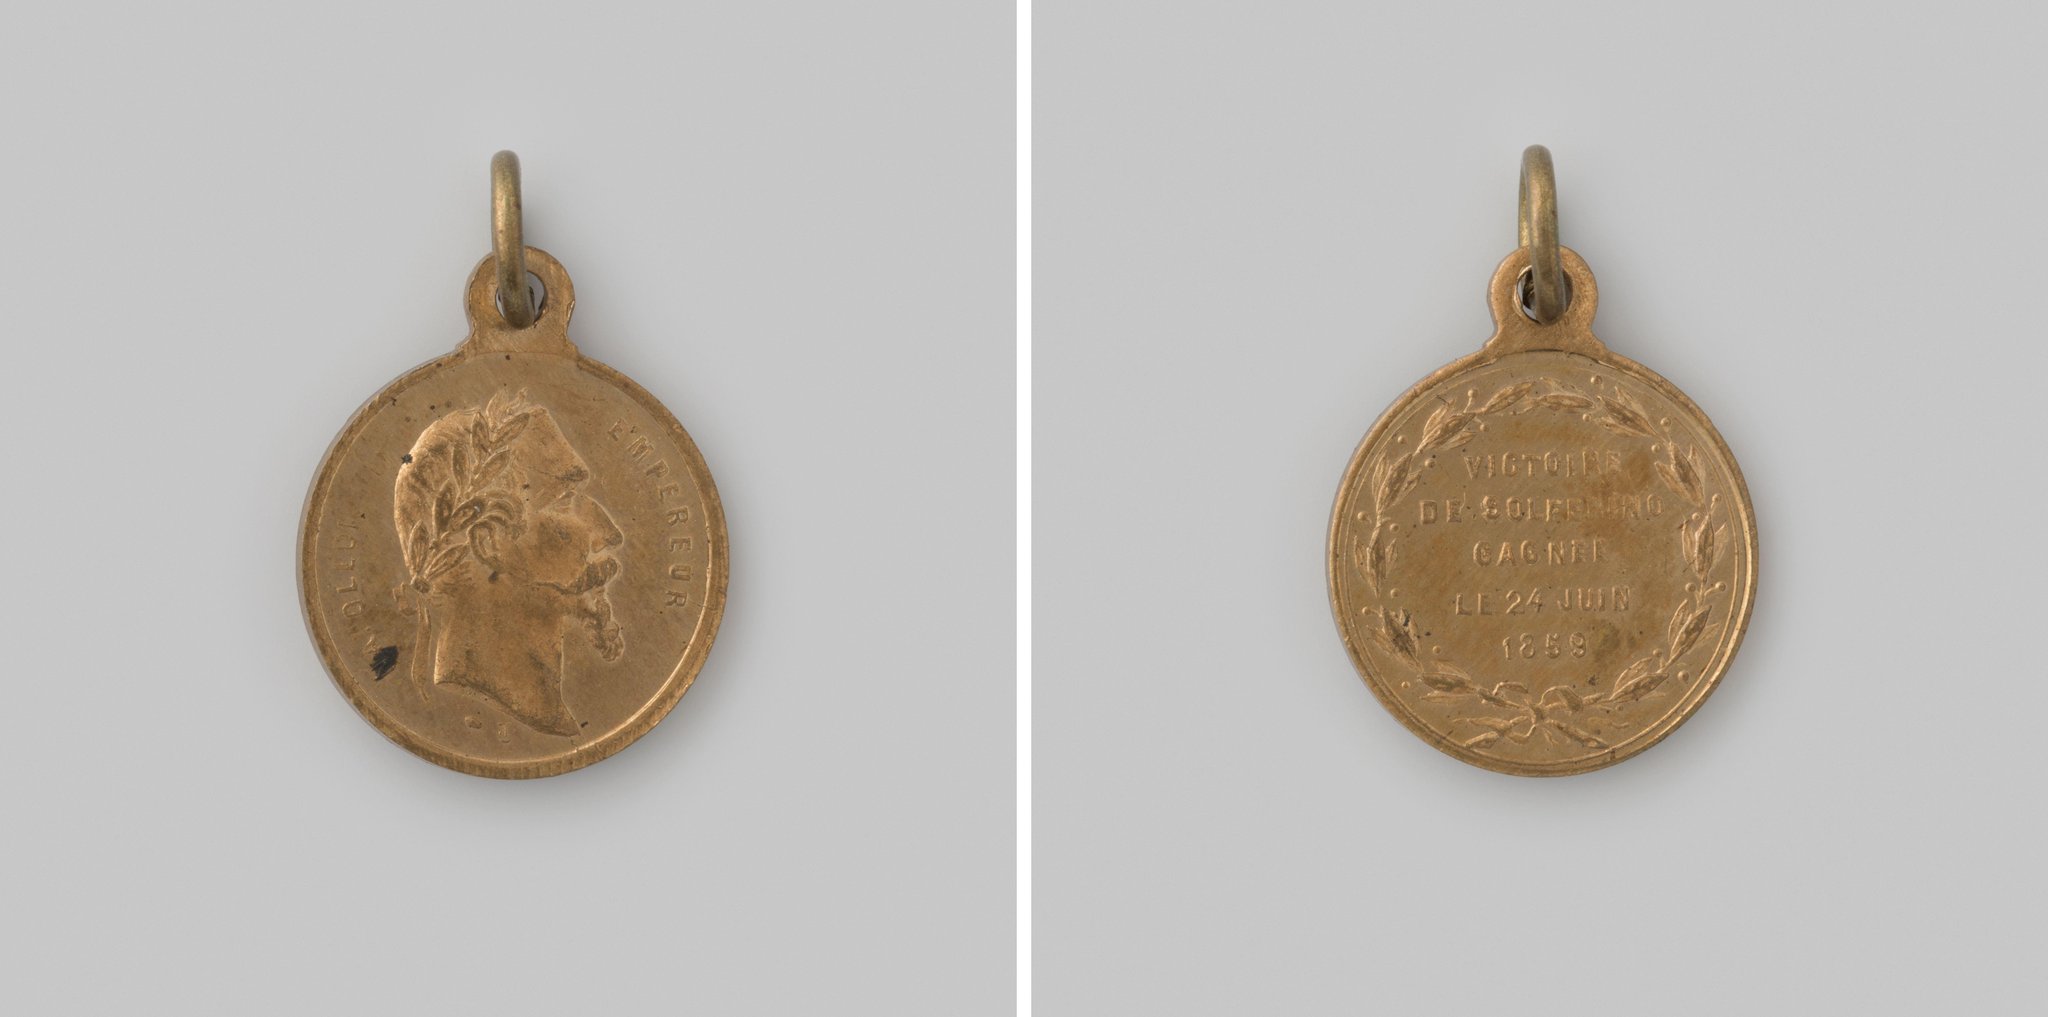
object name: history medal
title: Slag bij Solferino 1859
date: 1859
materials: brass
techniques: striking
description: Verguld penninkje met oog en draagring, op de voorzijde het portret van Keizer Napoleon III naar rechts met omschrift, op de keerzijde vijf regels tekst tussen samengestrikte lauwertakken.